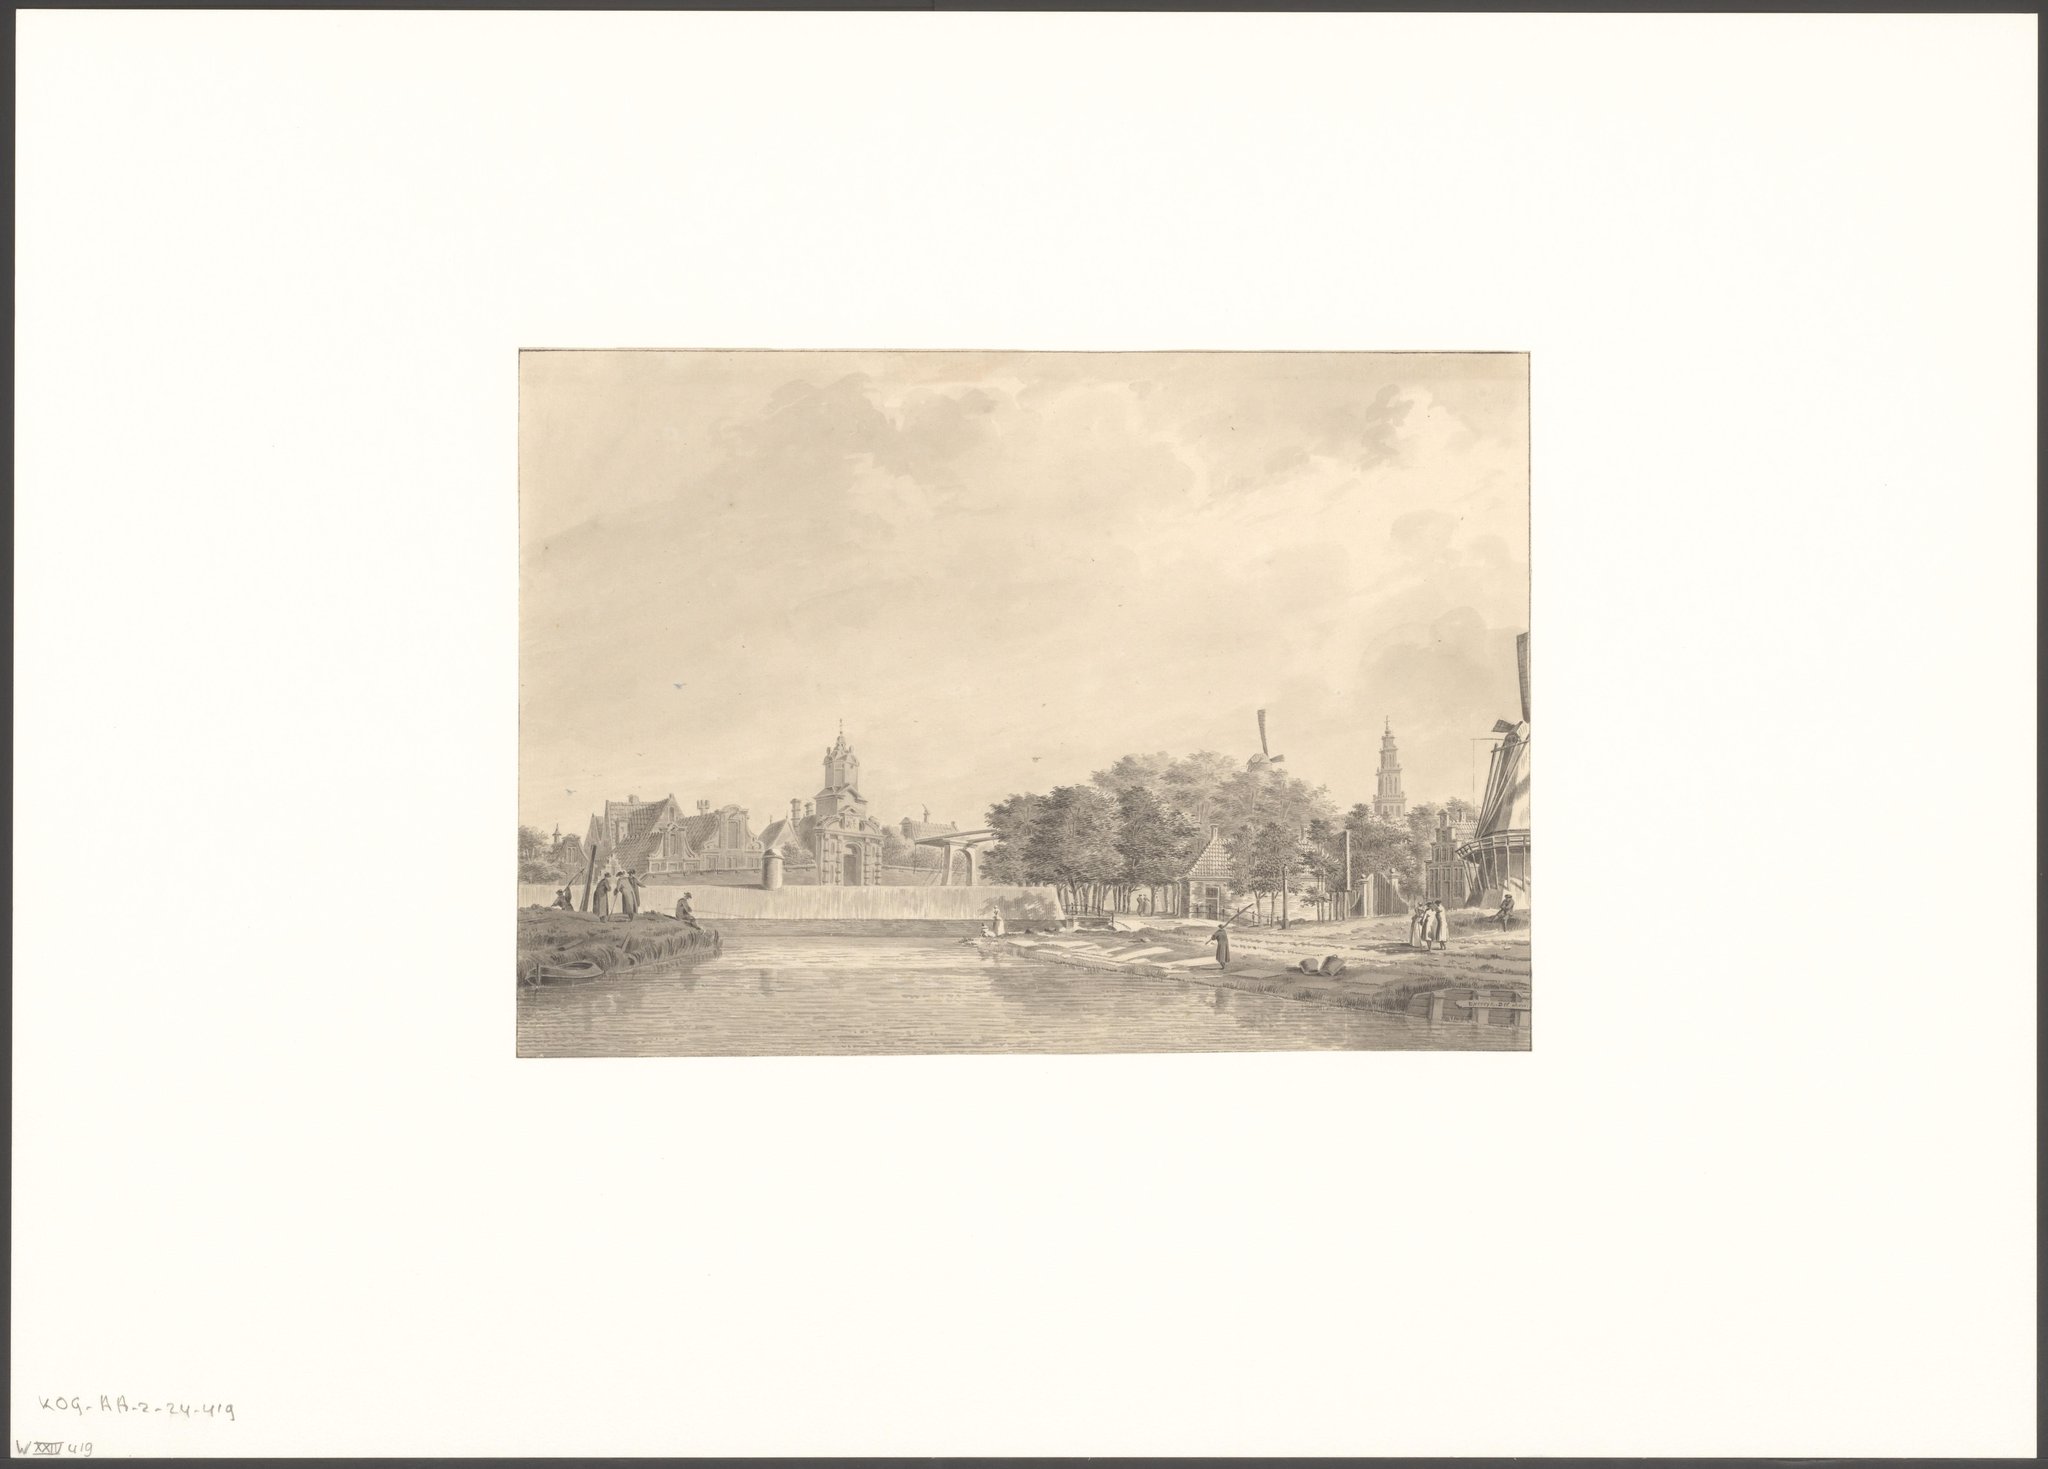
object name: drawing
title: Gezicht op de Haarlemmerpoort vanaf de Hoogendijk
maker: dirk verrijk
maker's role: draughtsman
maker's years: 1734-1786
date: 1744-1786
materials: ink, paper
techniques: brush, pen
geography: amsterdam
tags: city-view in general; 'veduta', canal, windmill in landscape, parts of church exterior and annexes: spire, city-gate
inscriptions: signature: ‘d.verryk.del ad.viv:’, inscription: ‘Haarlemmerpoort over de hoogedijk te zien’, collector's mark: Lugt 800a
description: Tekening binnen de Atlas Van Eck ingedeeld op wijknummer 24.